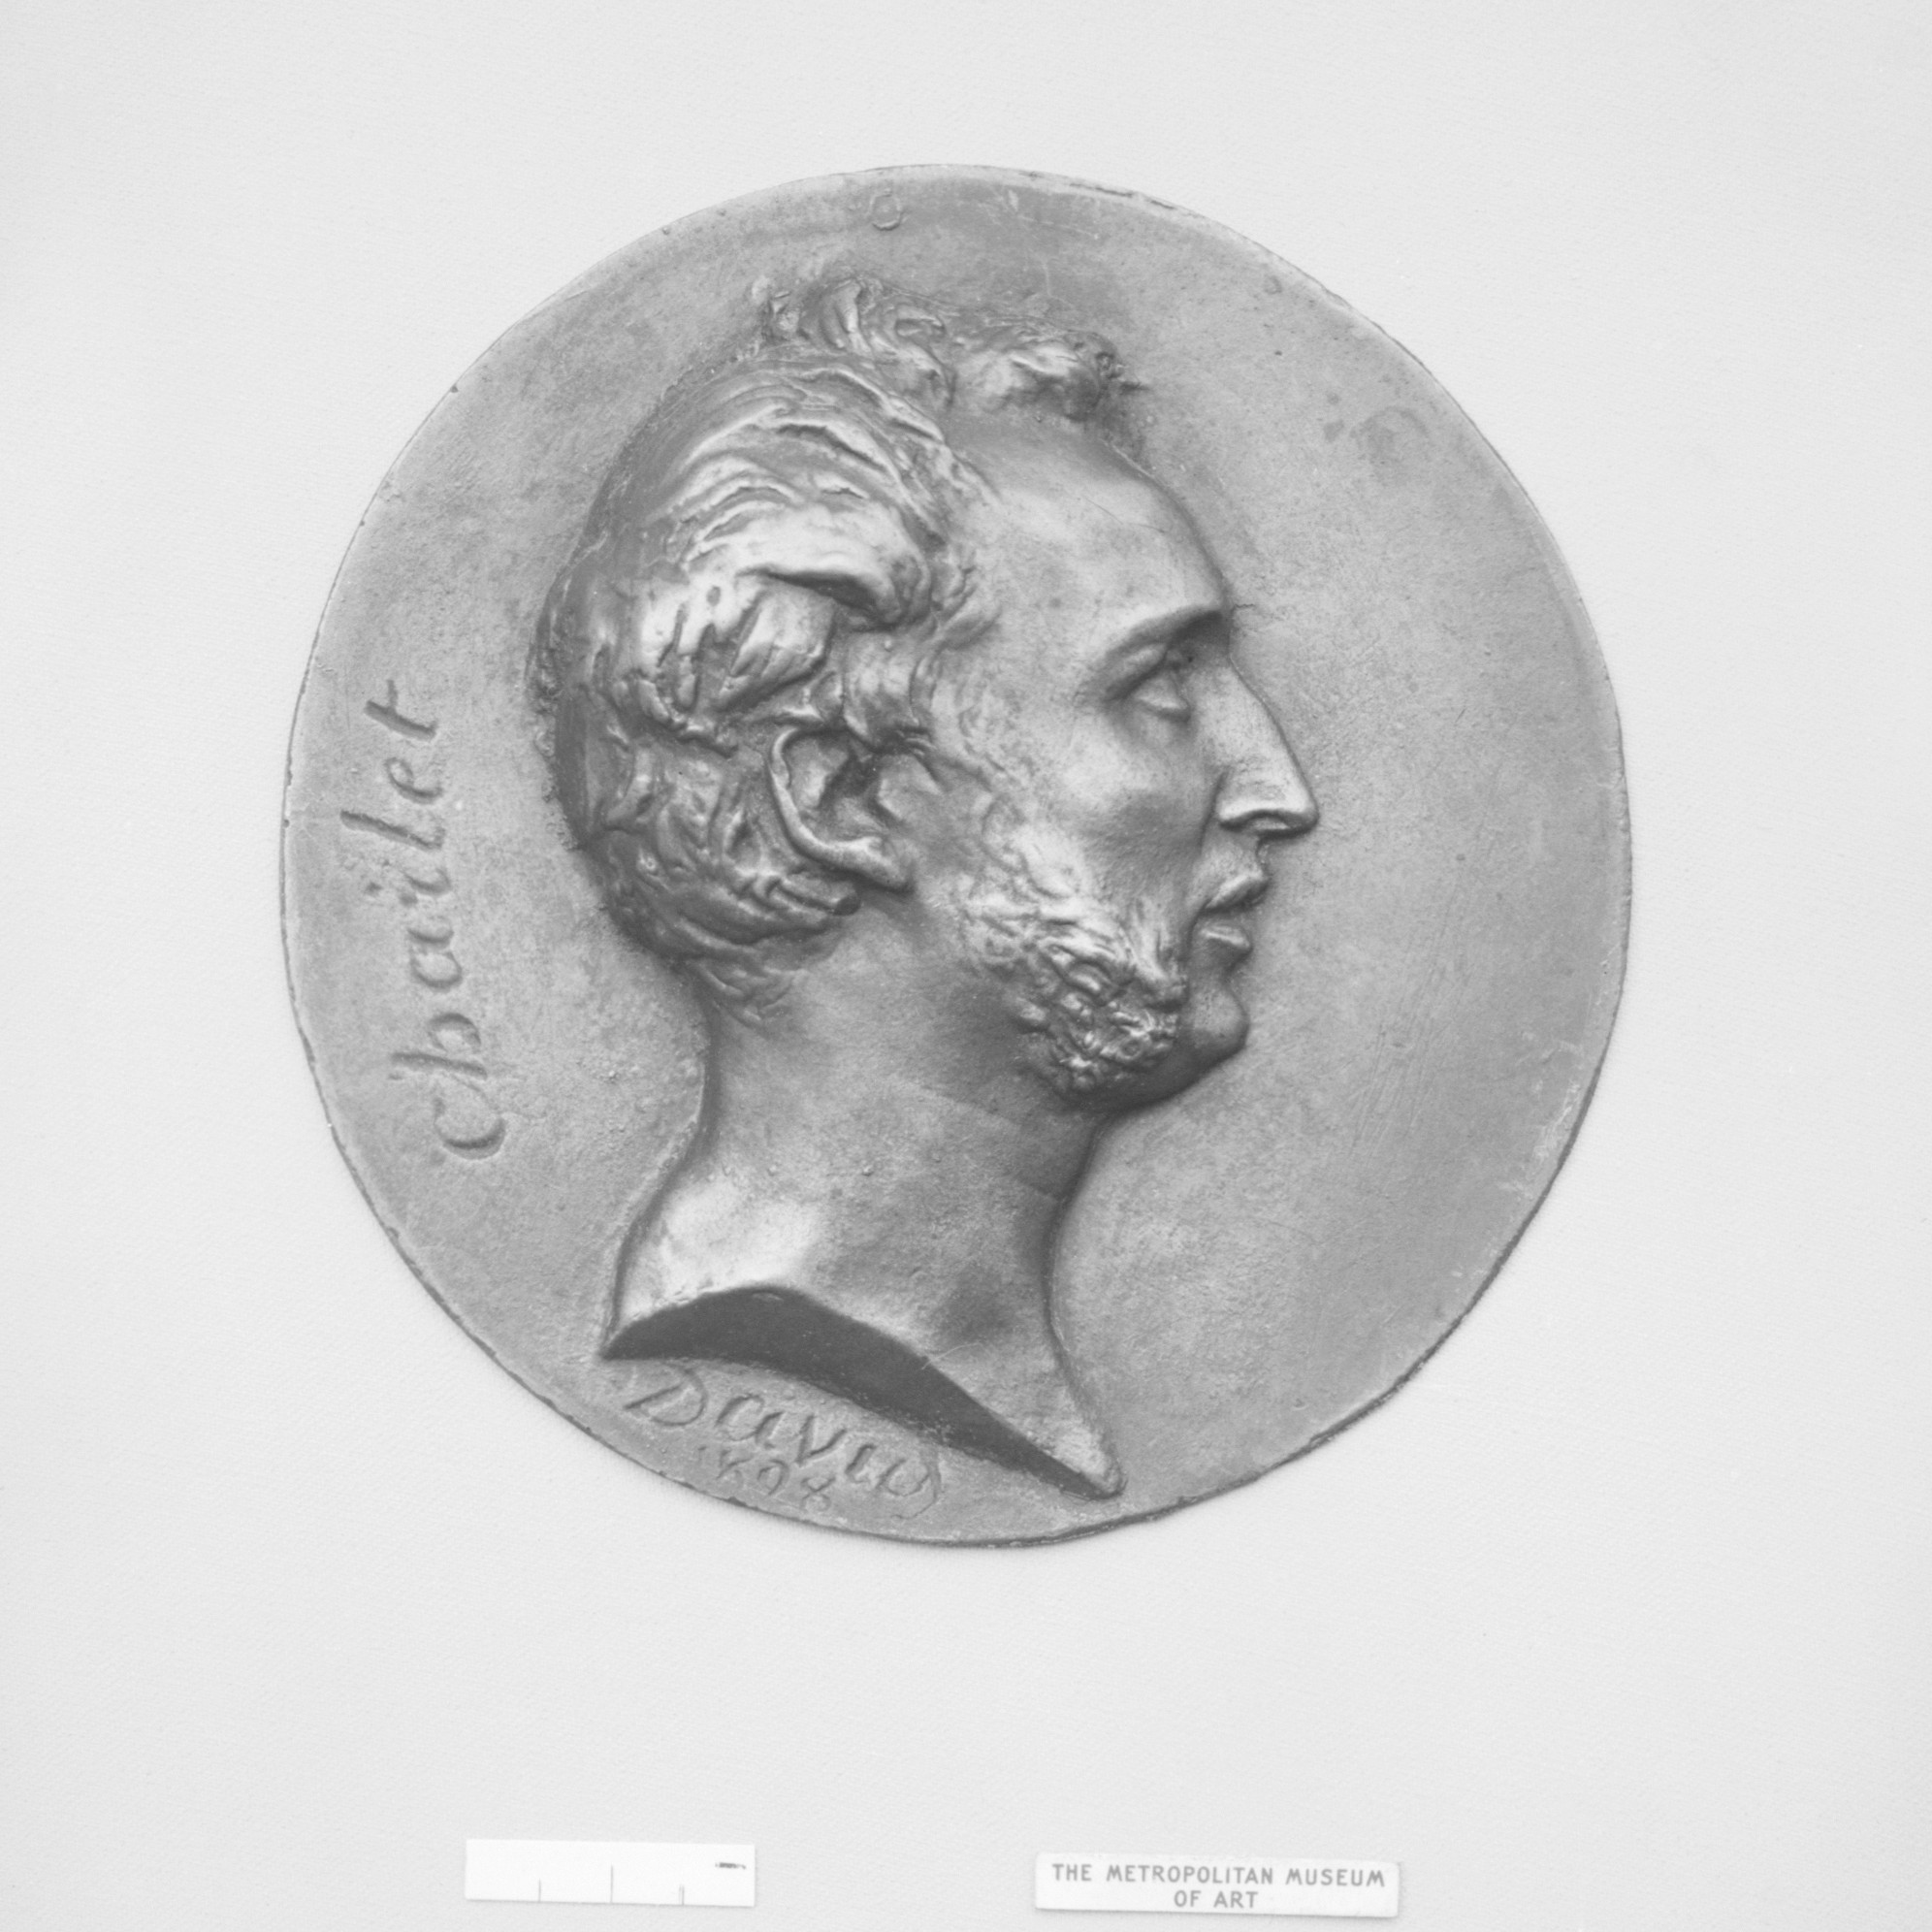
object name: medallion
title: Nicolas Toussaint Charlet (1792–1845), French painter of battle-pieces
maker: pierre jean david d'angers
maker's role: artist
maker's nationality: french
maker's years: 1788-1856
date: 1828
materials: bronze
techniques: casting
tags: men,profiles